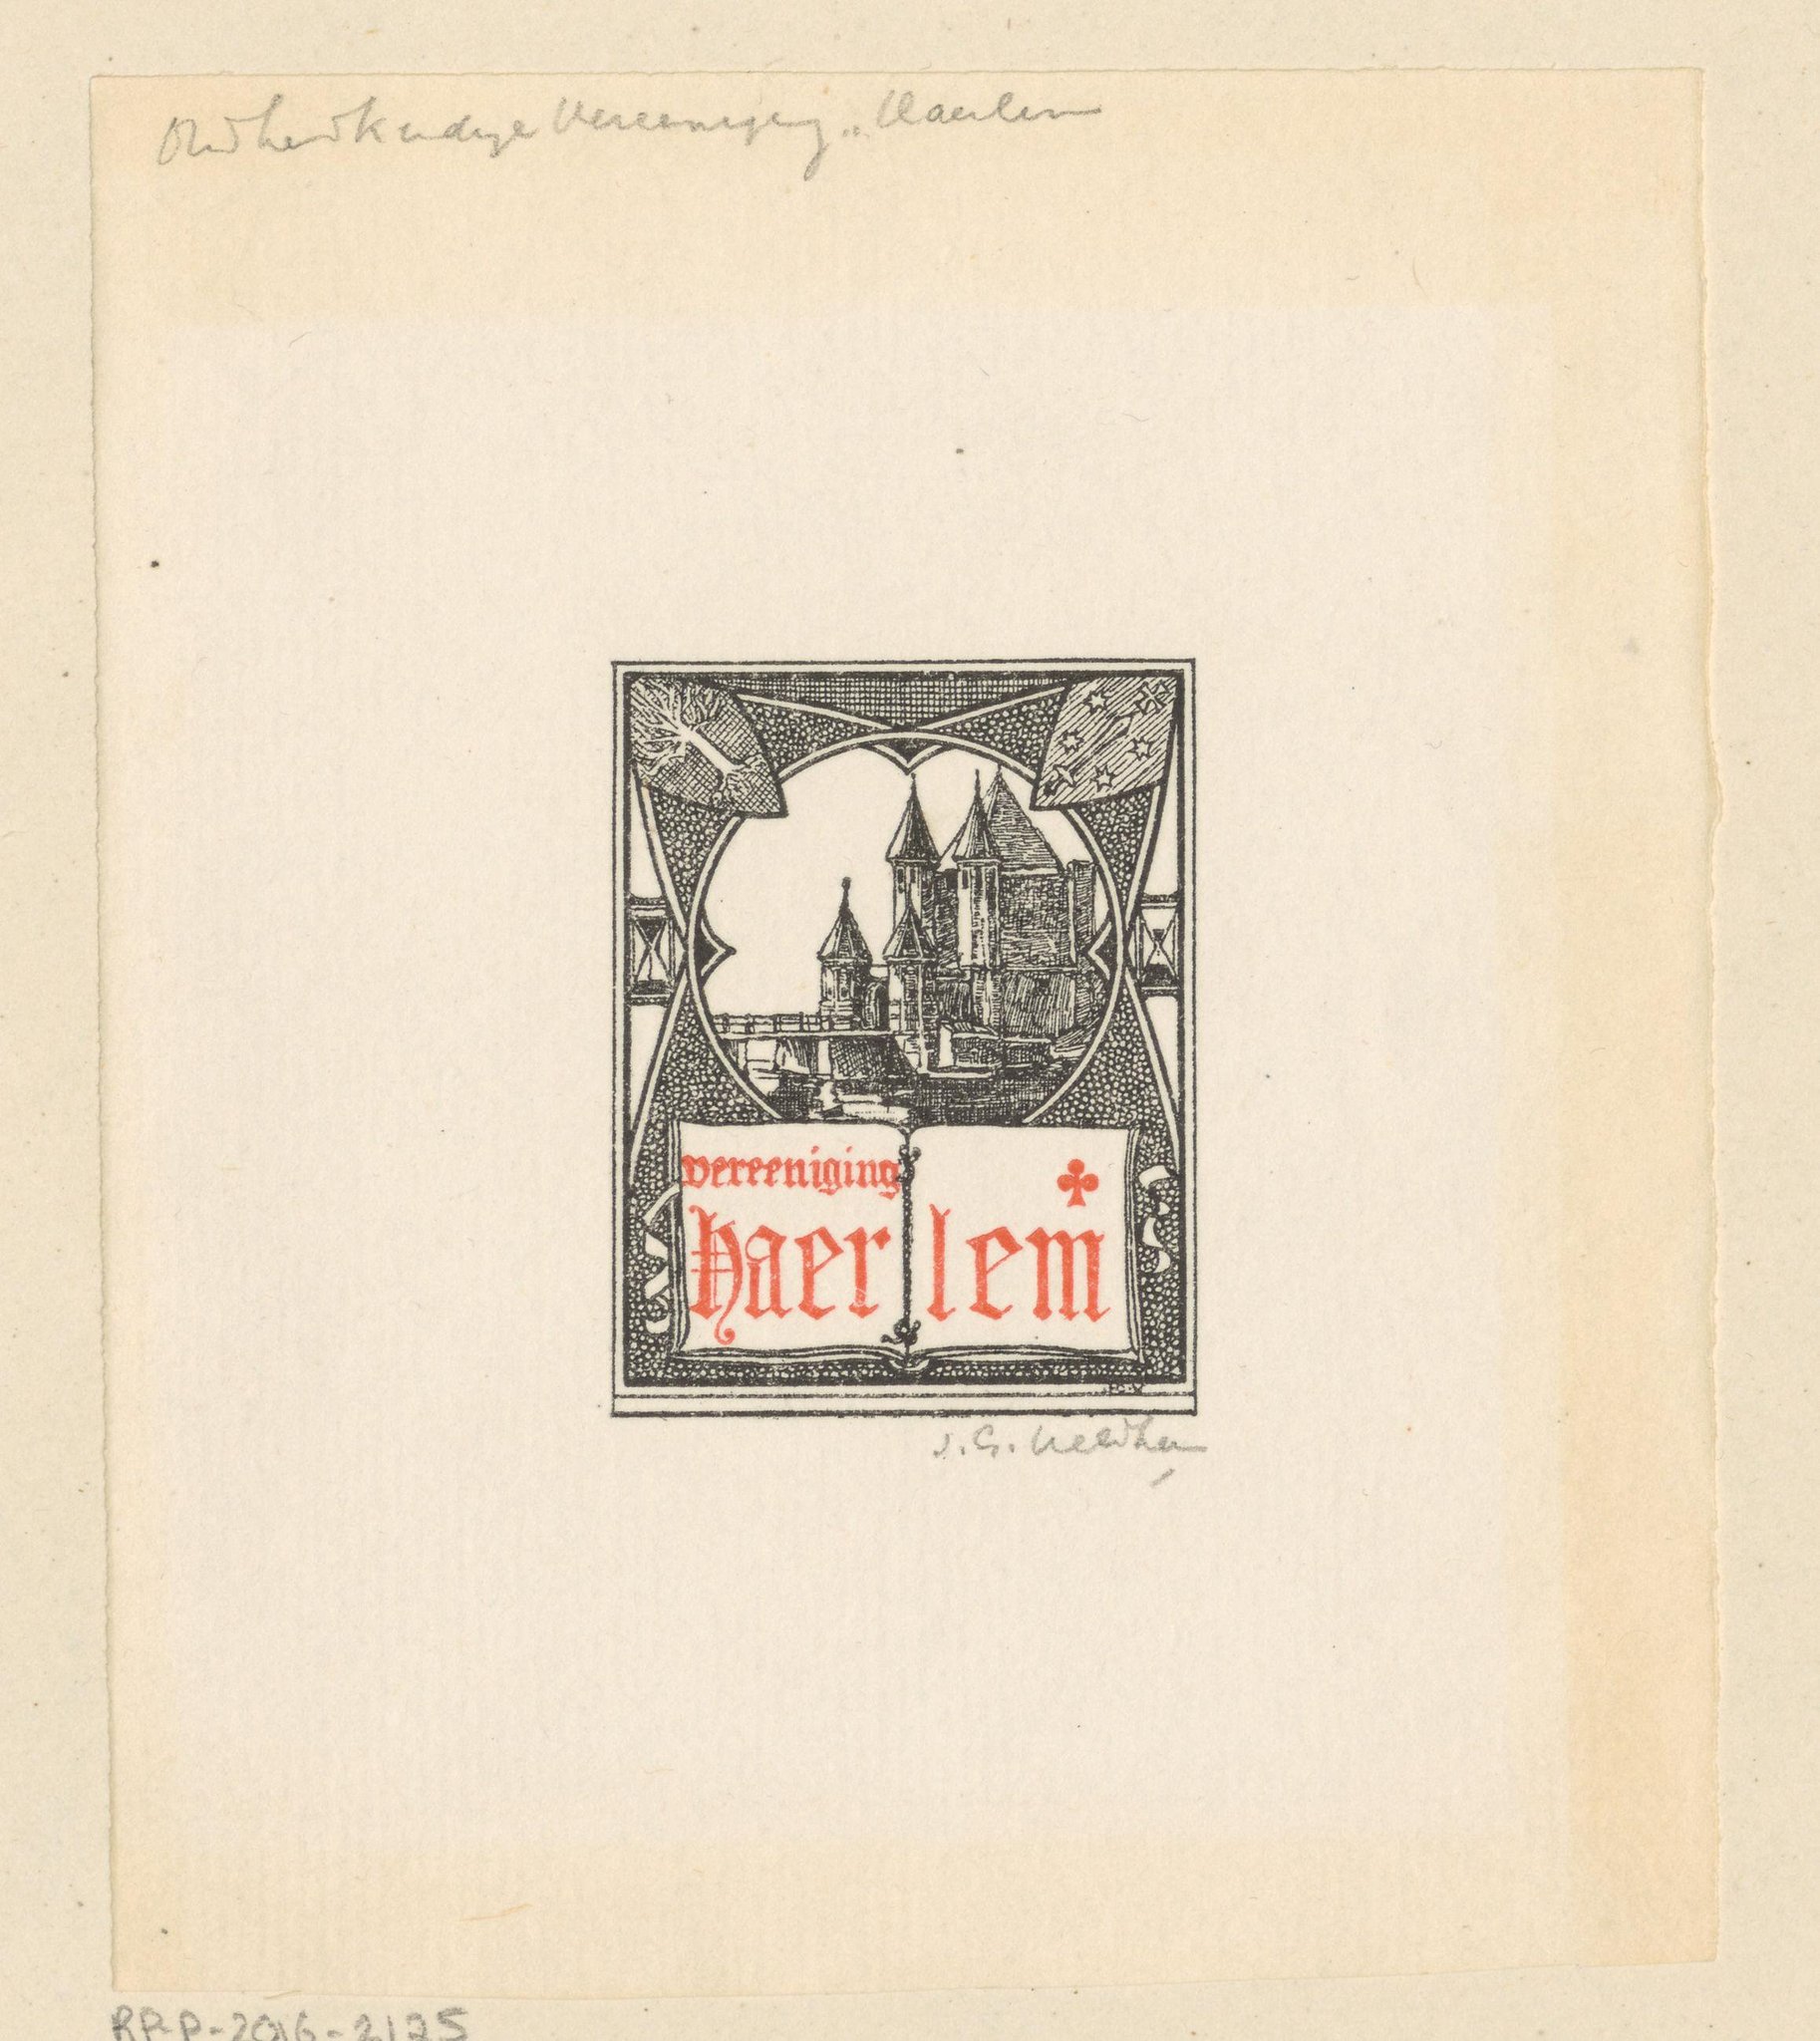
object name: bookplate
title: Ex libris van de Historische Vereniging Haerlem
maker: jacobus gerardus veldheer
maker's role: draughtsman, print maker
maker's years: 1866-1954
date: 1876-1954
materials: paper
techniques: printing block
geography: netherlands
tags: armorial bearing, heraldry, haarlem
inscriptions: signature: ‘J.G. Veldheer’, inscription: ‘Oudheidkundige Vereeniging "Haerlem"’